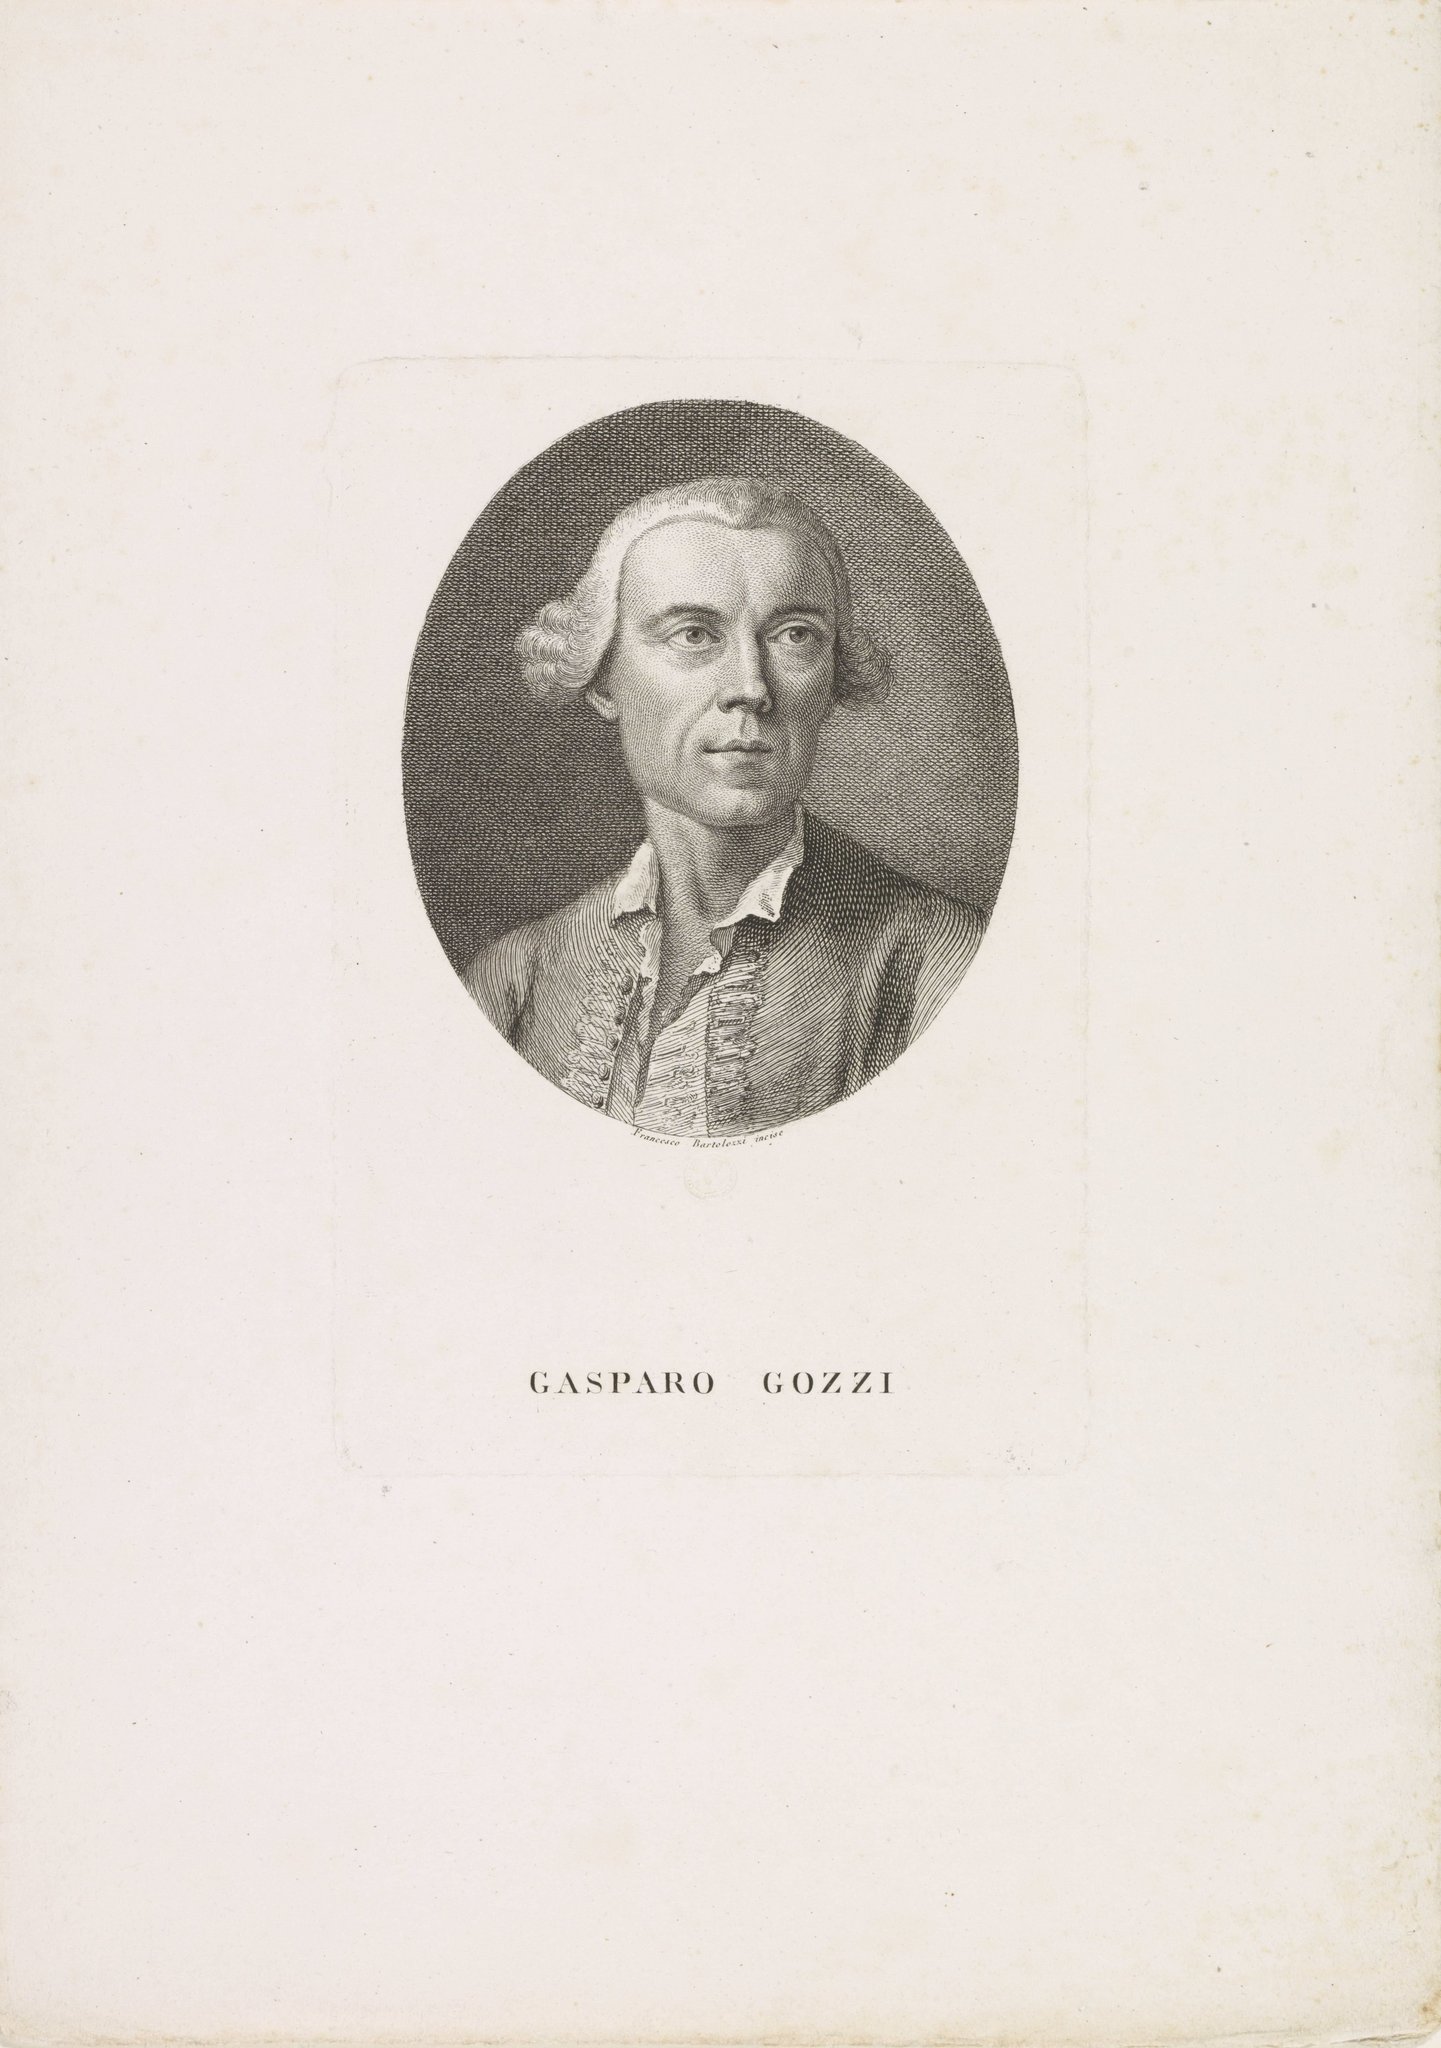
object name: print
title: Portretten van beroemde Italianen in ovalen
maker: francesco bartolozzi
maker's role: draughtsman, print maker, publisher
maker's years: 1727-1815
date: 1738-1815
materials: paper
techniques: engraving, etching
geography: italy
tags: venice, historical persons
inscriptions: collector's mark: Lugt 4187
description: Deze prent maakt deel uit van een reeks portretprenten van onbekende omvang. De reeks is in meerdere staten uitgegeven. De eerste staat met enkel het portret in ovaal. Een tweede staat met naam van de geportretteerde in holle letters onder de voorstelling. Een derde staat met de naam van de geportretteerde in gevulde letters onder de voorstelling. En een vierde staat met een rechthoekig kader rondom het ovale portret.